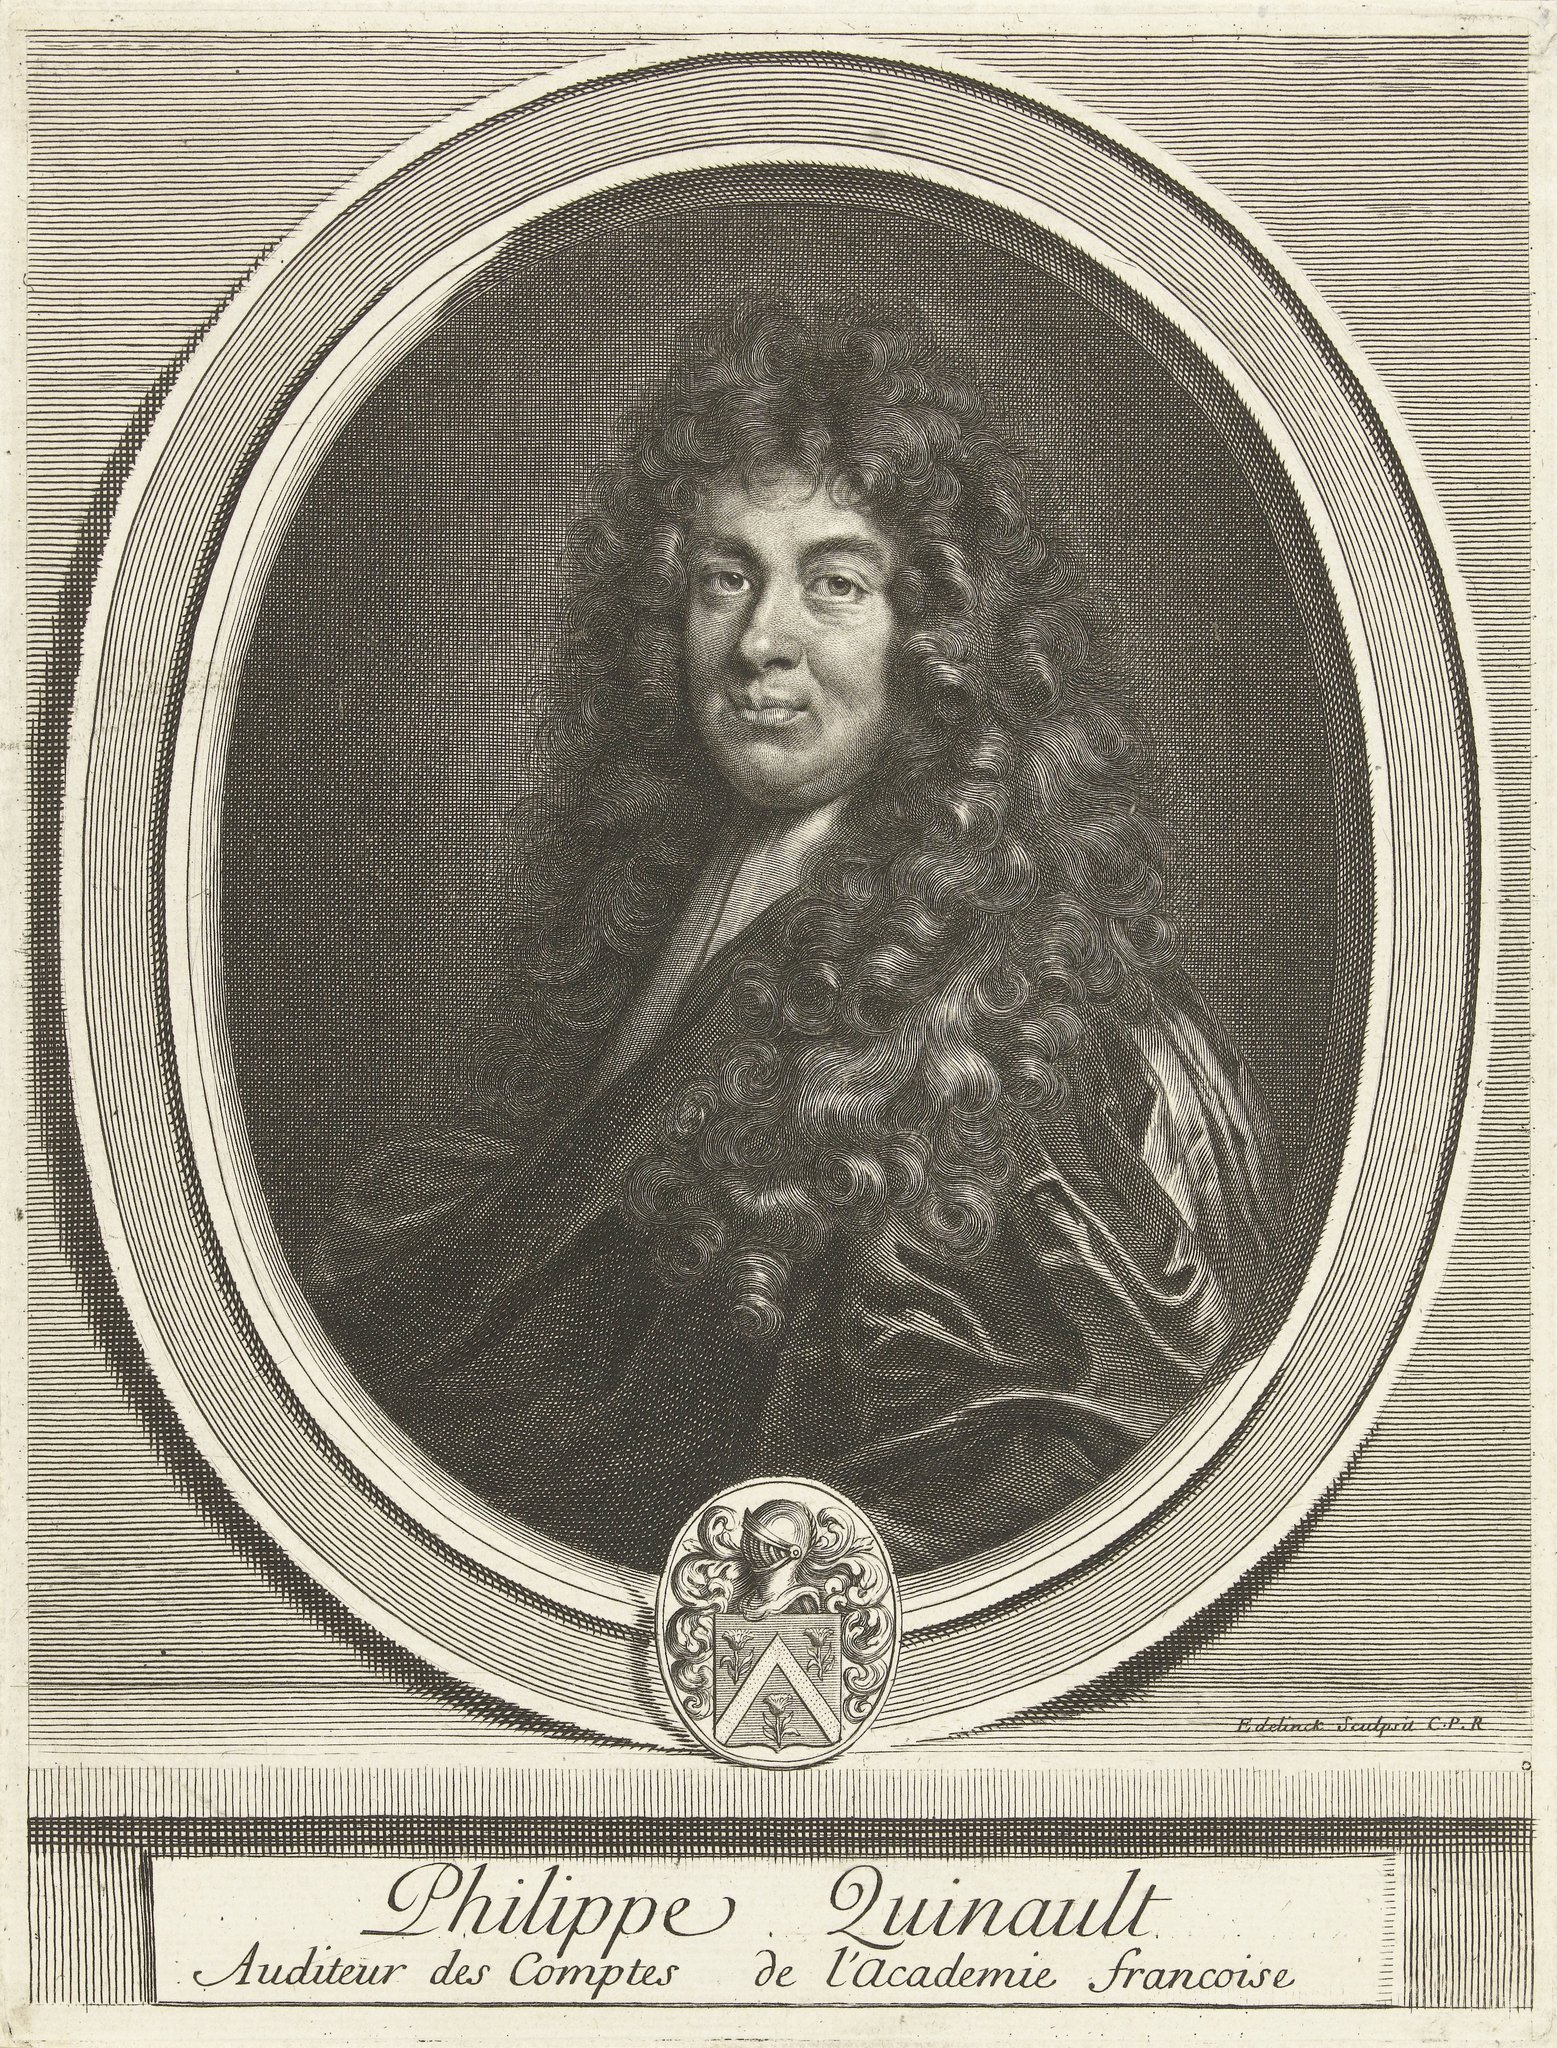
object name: print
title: Portret van Philippe Quinault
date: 1666-1707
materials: paper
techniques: engraving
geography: paris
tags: paris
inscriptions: collector's mark: Lugt 240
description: Portret van de Franse toneelschrijver en librettist Philippe Quinault (1635-1688), afgebeeld in ovale omlijsting met wapen.